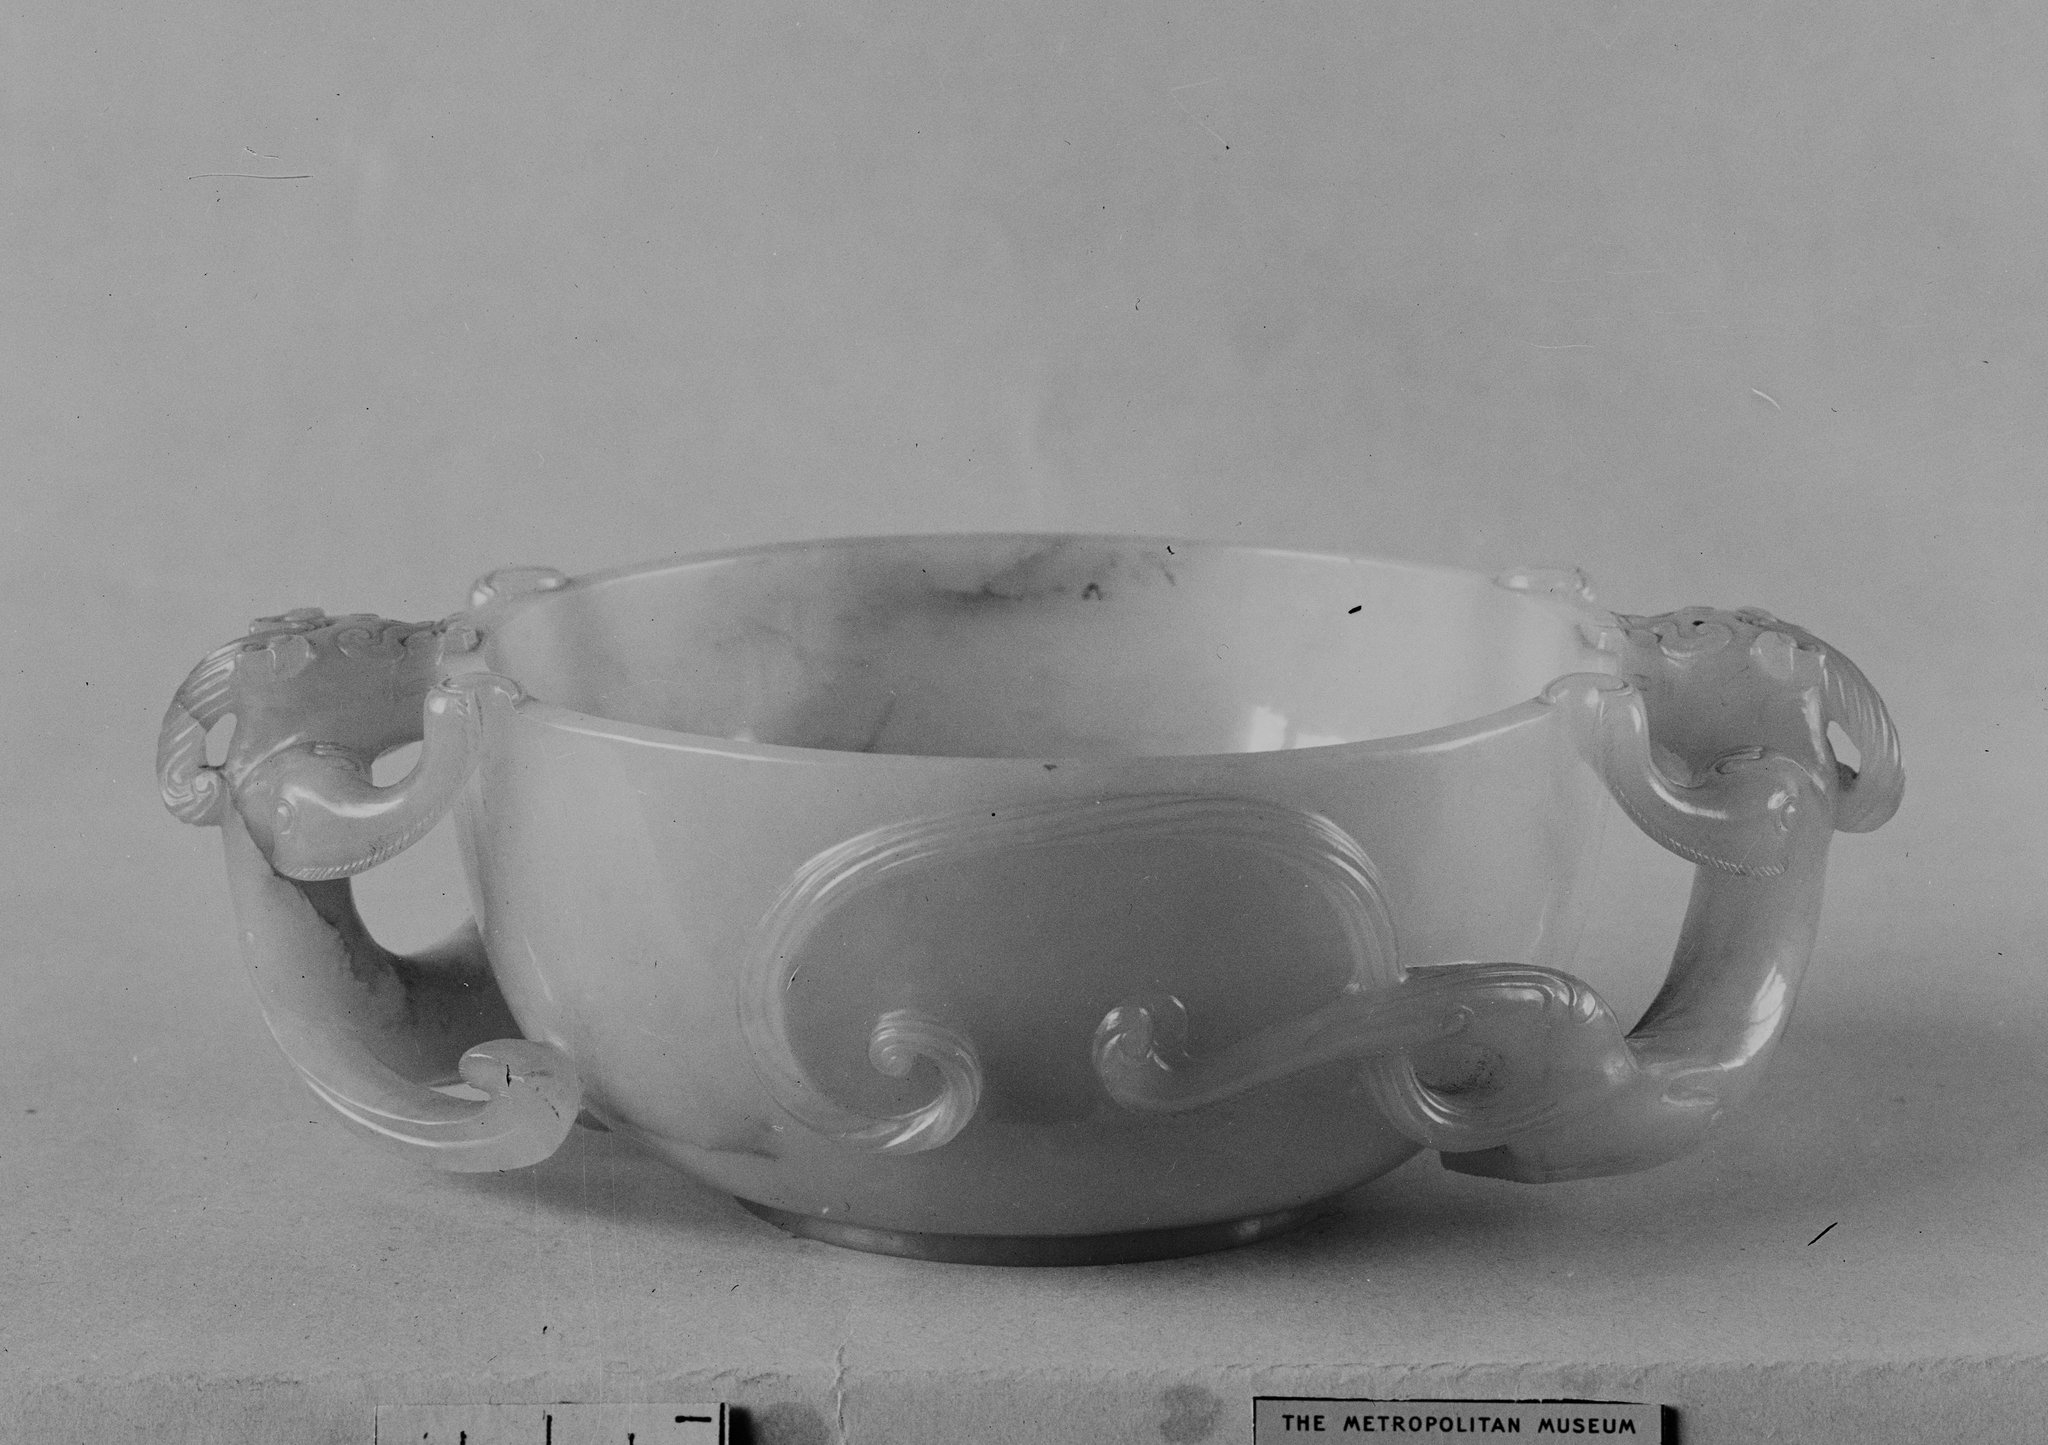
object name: cup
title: Cup with dragon handles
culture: chinese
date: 1601-1700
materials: jade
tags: dragons